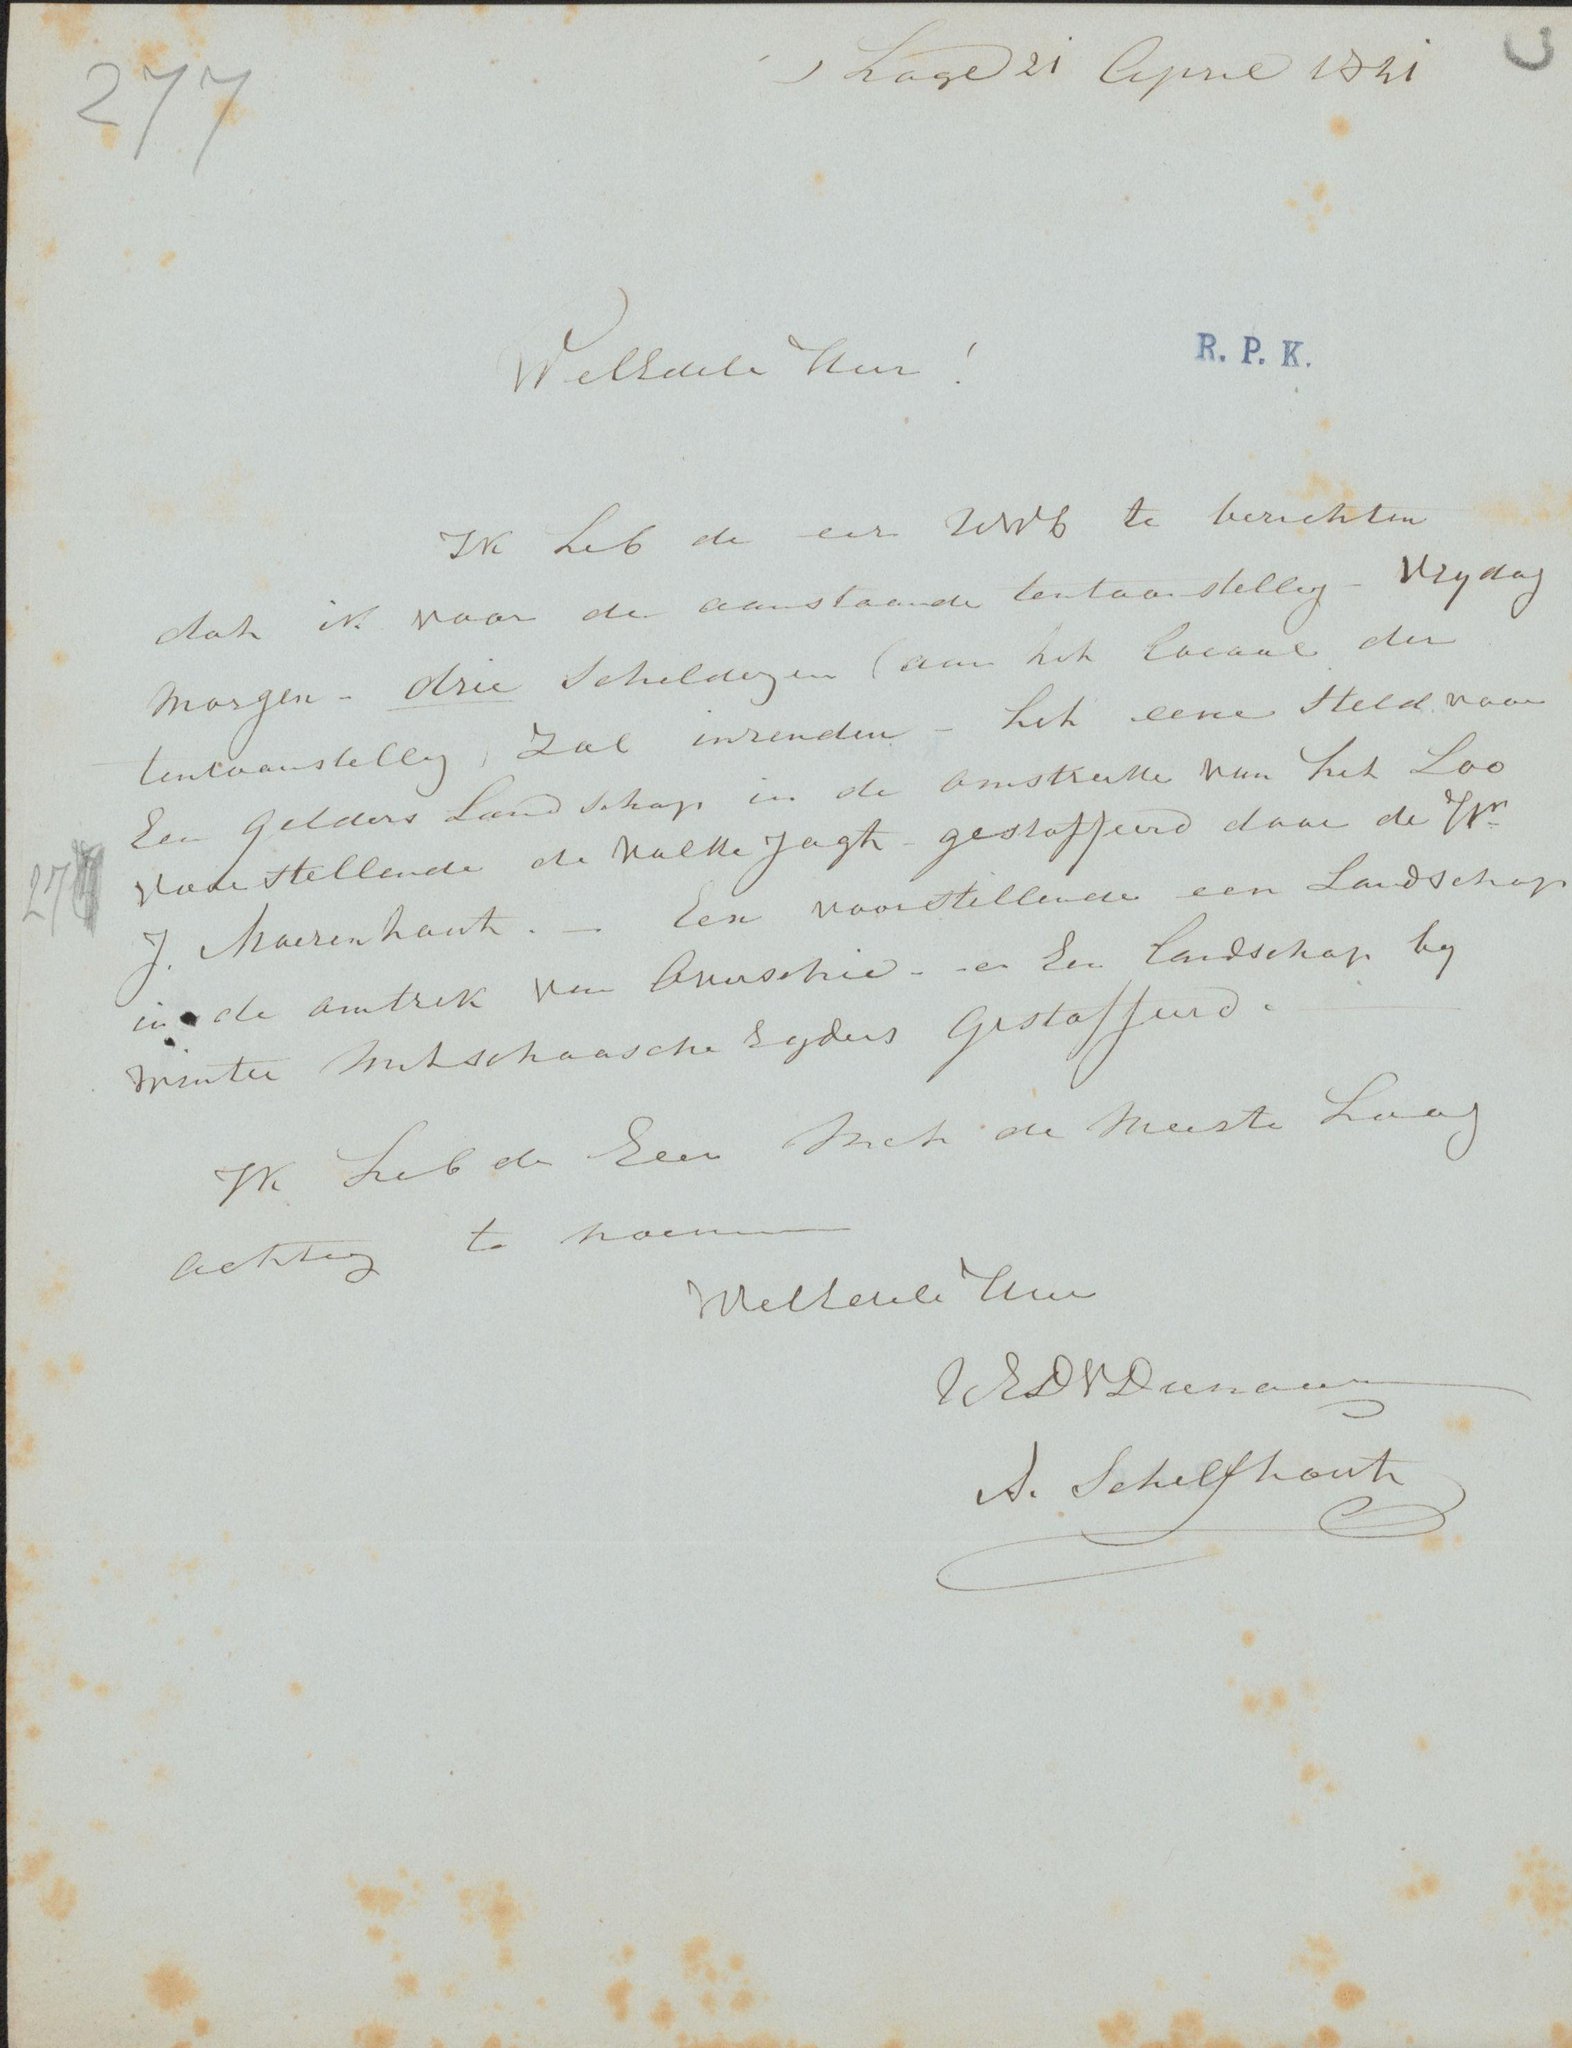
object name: letter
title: Brief aan G.M.C. Hooft, secretaris van de commissie van de Tentoonstelling van Levende Meesters in Den Haag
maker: andreas schelfhout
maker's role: draughtsman, painter, print maker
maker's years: 1787-1870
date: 1841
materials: ink, paper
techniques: pen, writing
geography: the hague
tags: painting (including book-illumination, miniature-painting), exhibition ~ art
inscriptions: collector's mark: Lugt 2233